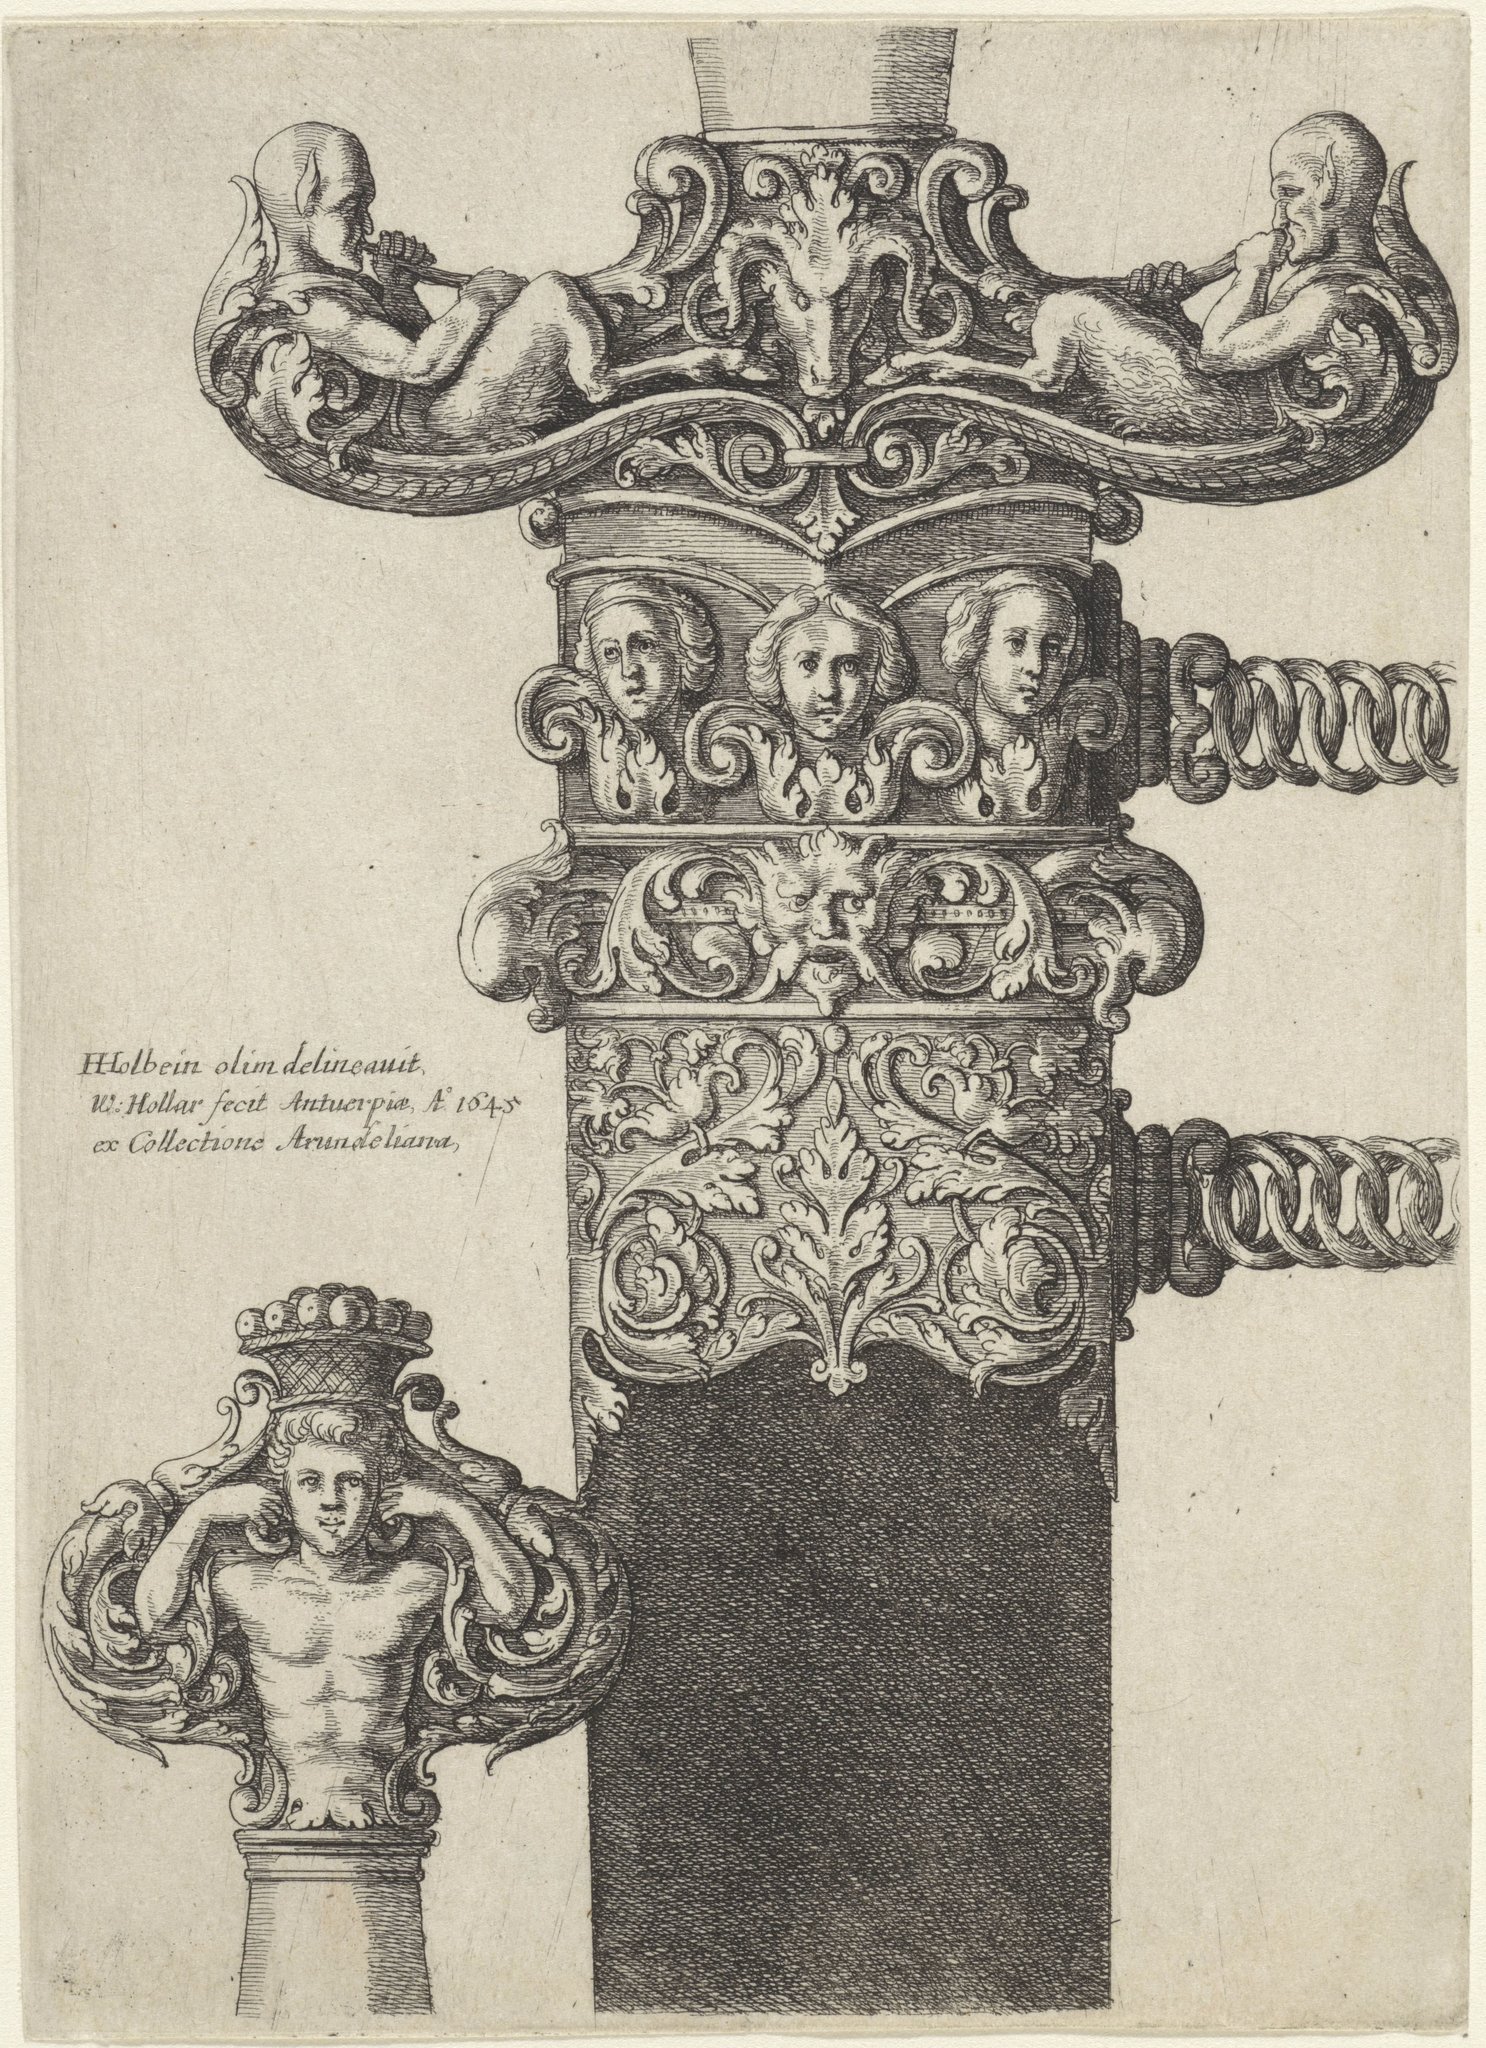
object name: print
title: Ornamenteel ontwerp voor een dolk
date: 1645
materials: paper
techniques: etching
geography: antwerp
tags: hacking and thrusting weapons: dagger, scabbard, sheath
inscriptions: date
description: Prent maakt deel uit van een tweedelige serie met ontwerpen voor ornamentele dolken.